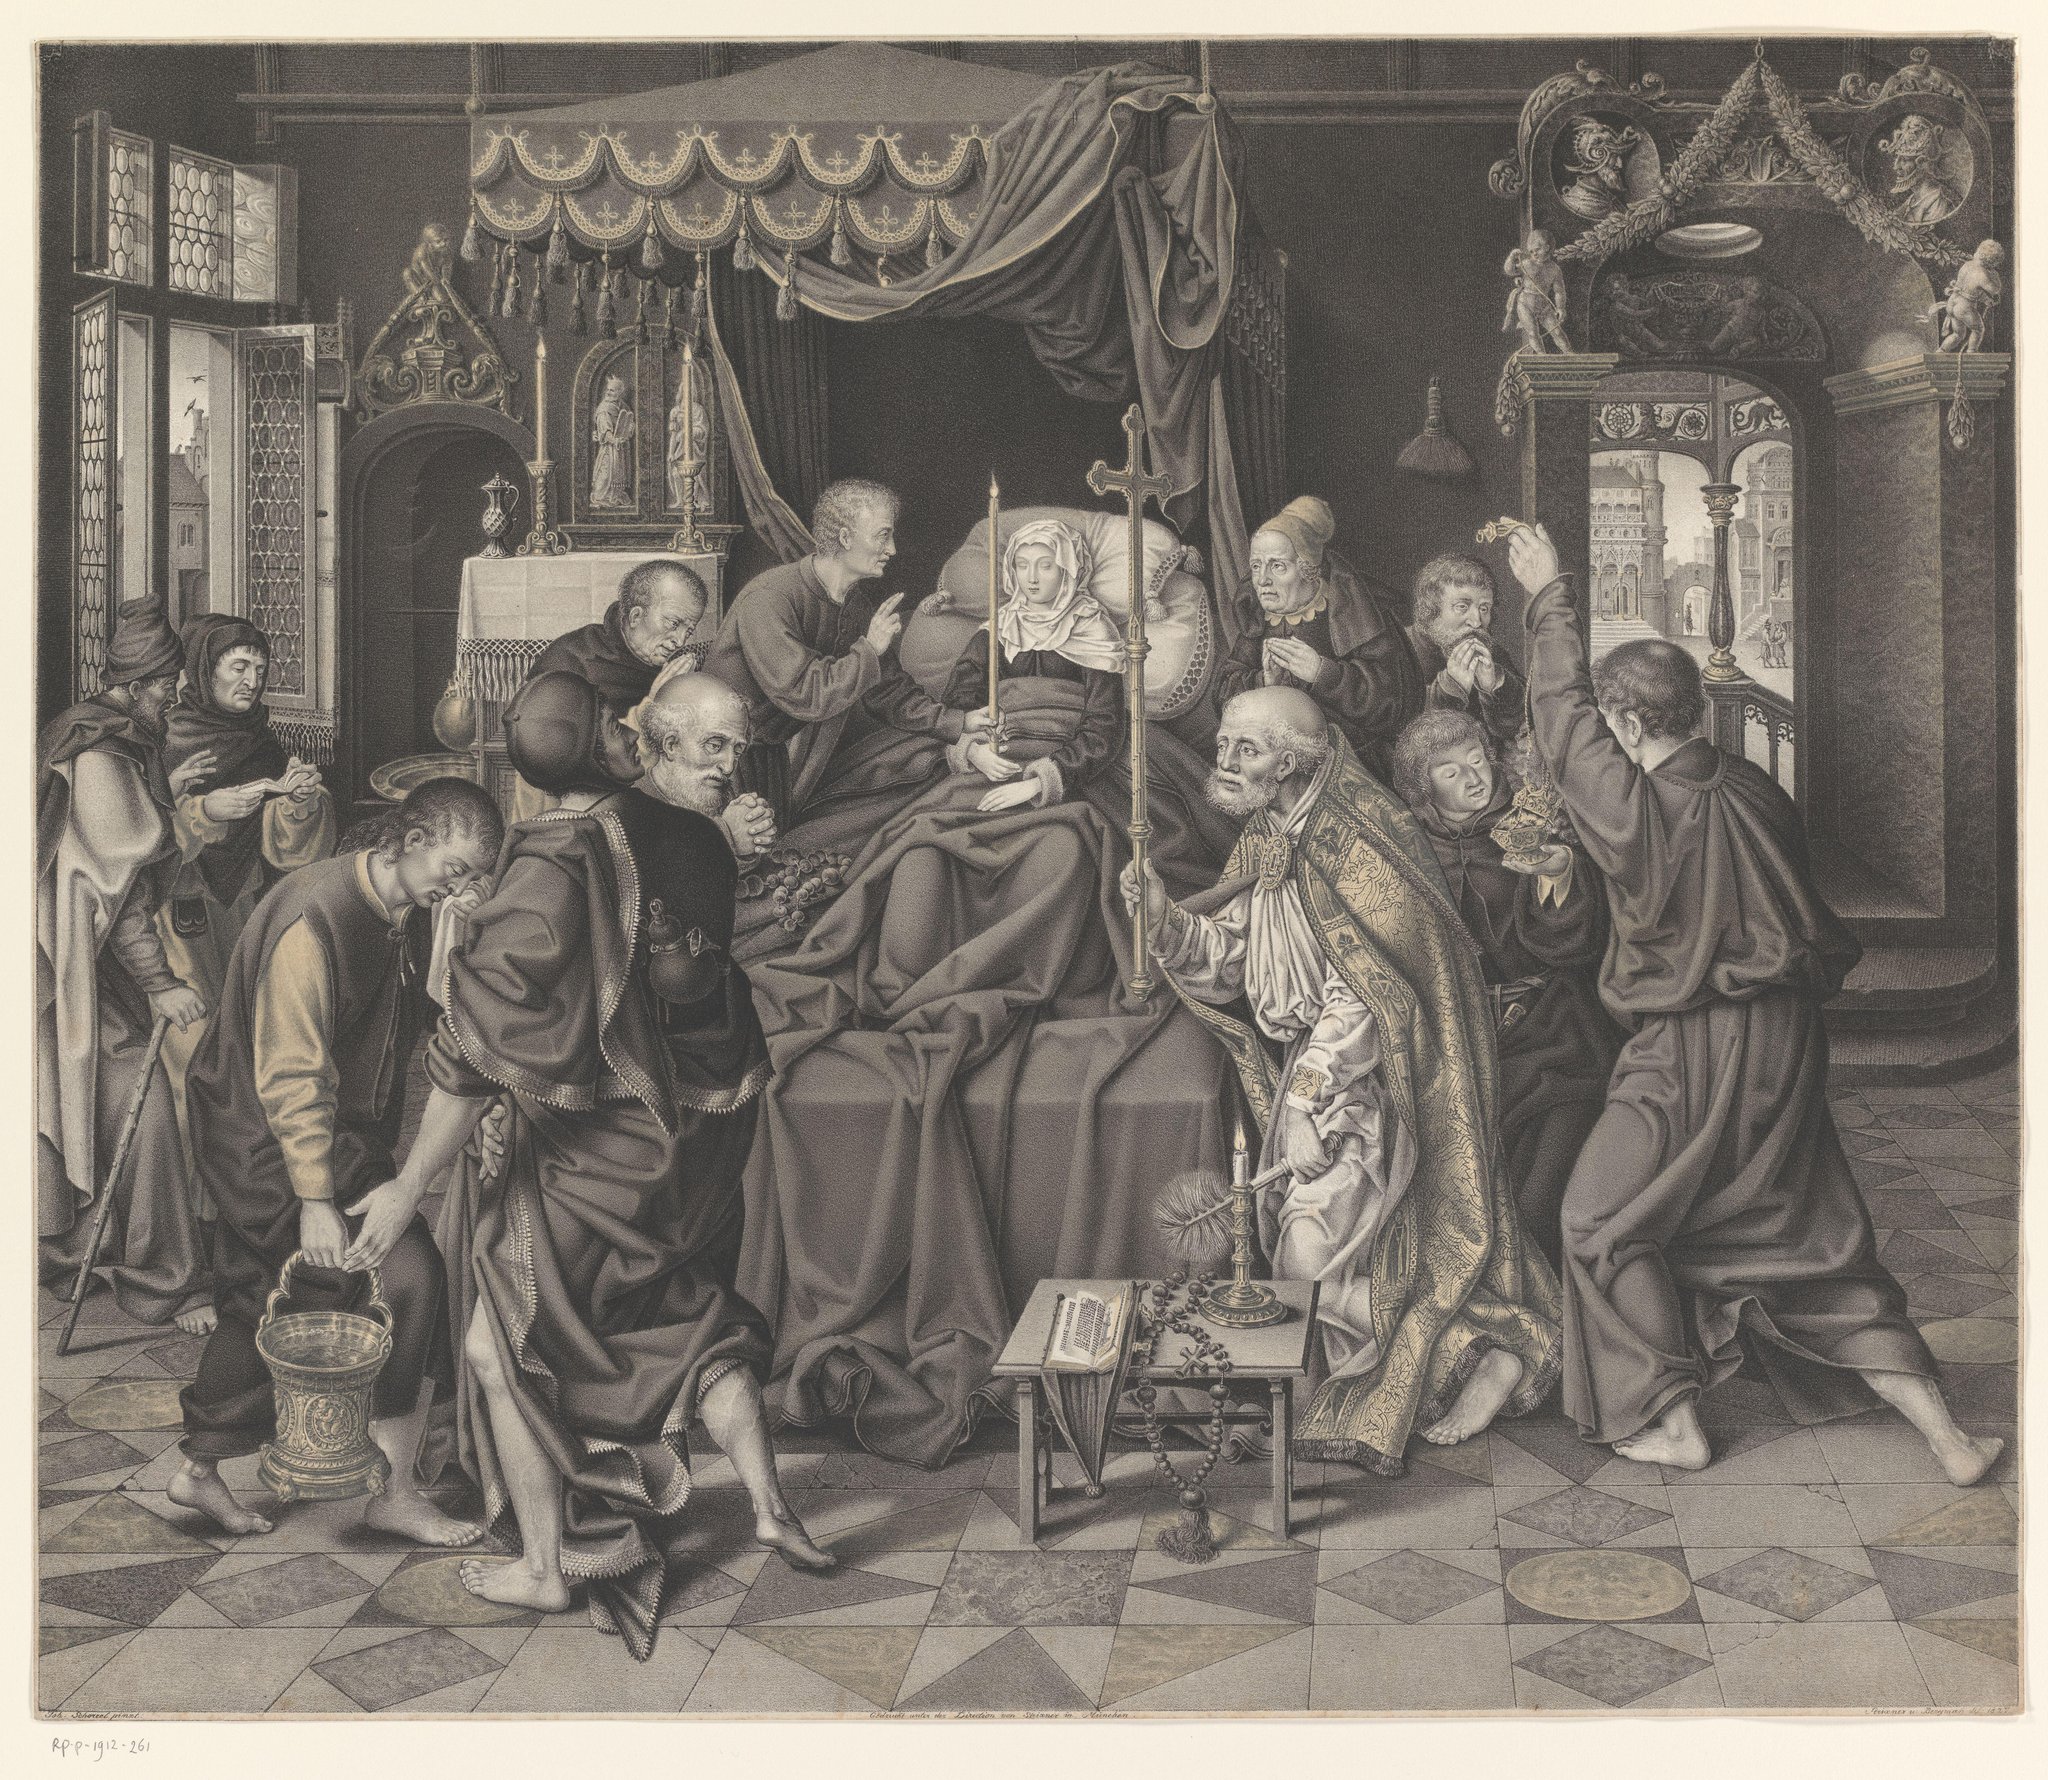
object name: print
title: Maria op haar sterfbed omringd door apostelen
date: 1827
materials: paper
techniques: tone lithography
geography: munich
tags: the dormition: mary on her deathbed; the apostles are gathered around her (john the evangelist may be shown sleeping or dreaming), bed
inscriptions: collector's mark: Lugt 2228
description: Deze prent behoort tot de serie 'Galerie des Frères Boisserée'. De serie is in 38 delen uitgegeven met drie prenten per deel en nog drie extra inleidende prenten. Deze prent verscheen in het twintigste deel.